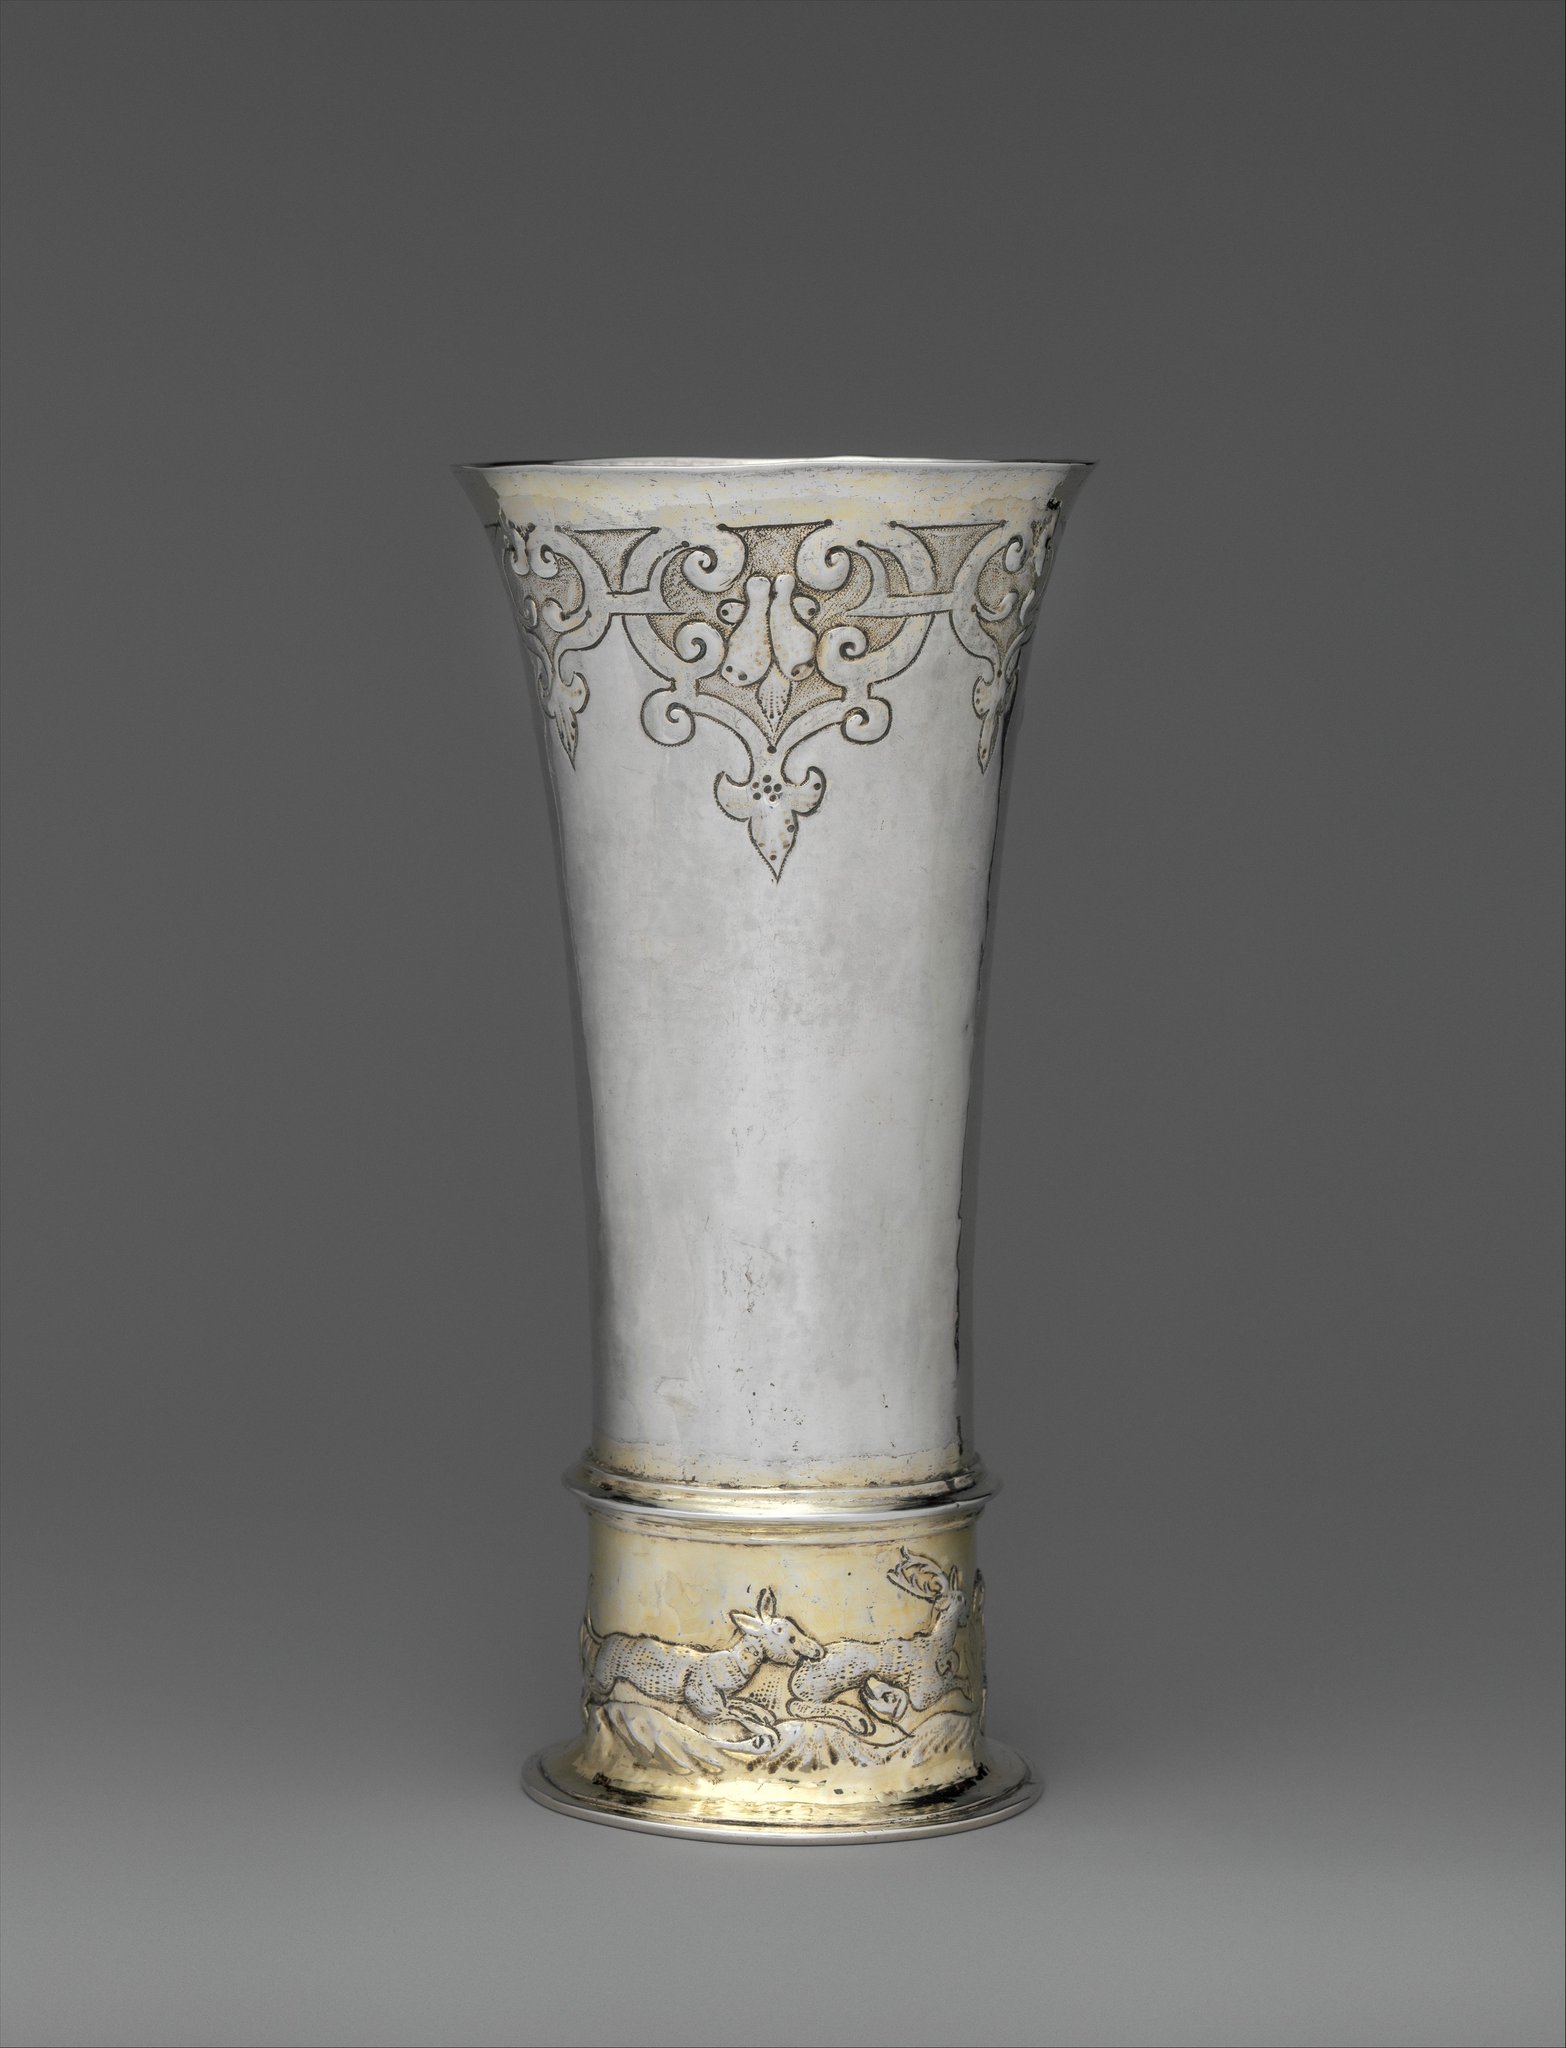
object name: beaker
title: Footed beaker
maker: thomas trepches ii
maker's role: maker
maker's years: 1576-1676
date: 1634-1666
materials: silver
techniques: gilding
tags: deer,dogs